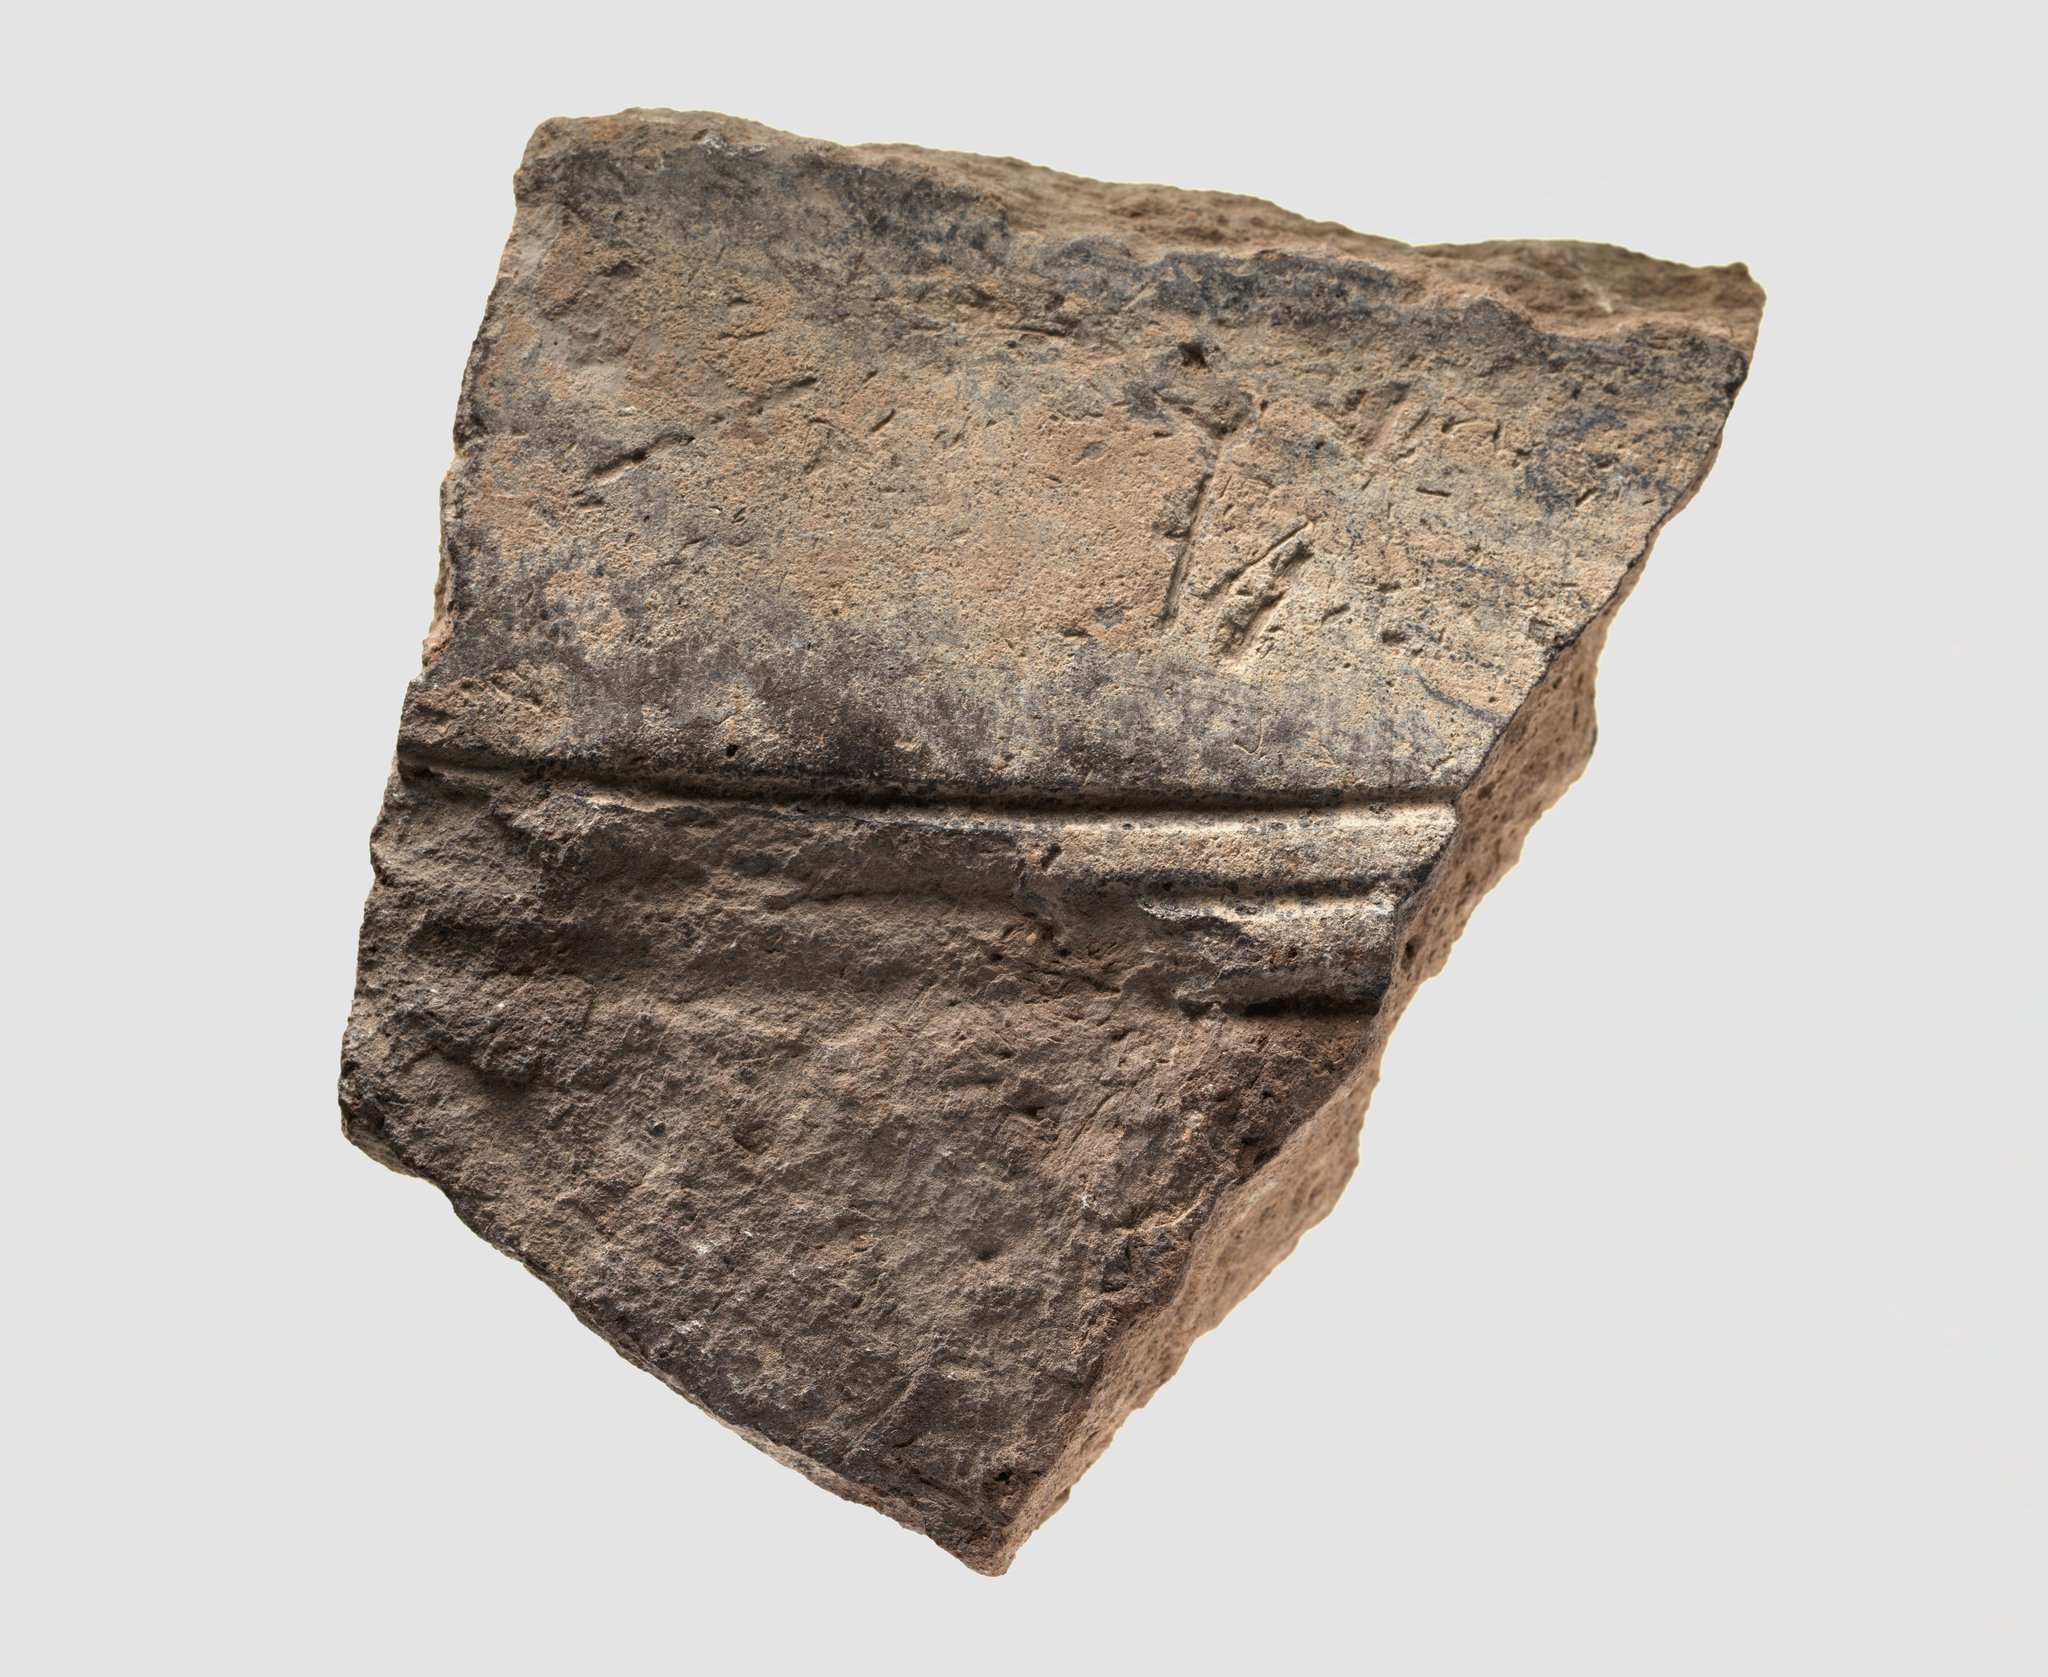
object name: sherd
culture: sasanian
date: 201-700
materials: ceramic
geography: mesopotamia